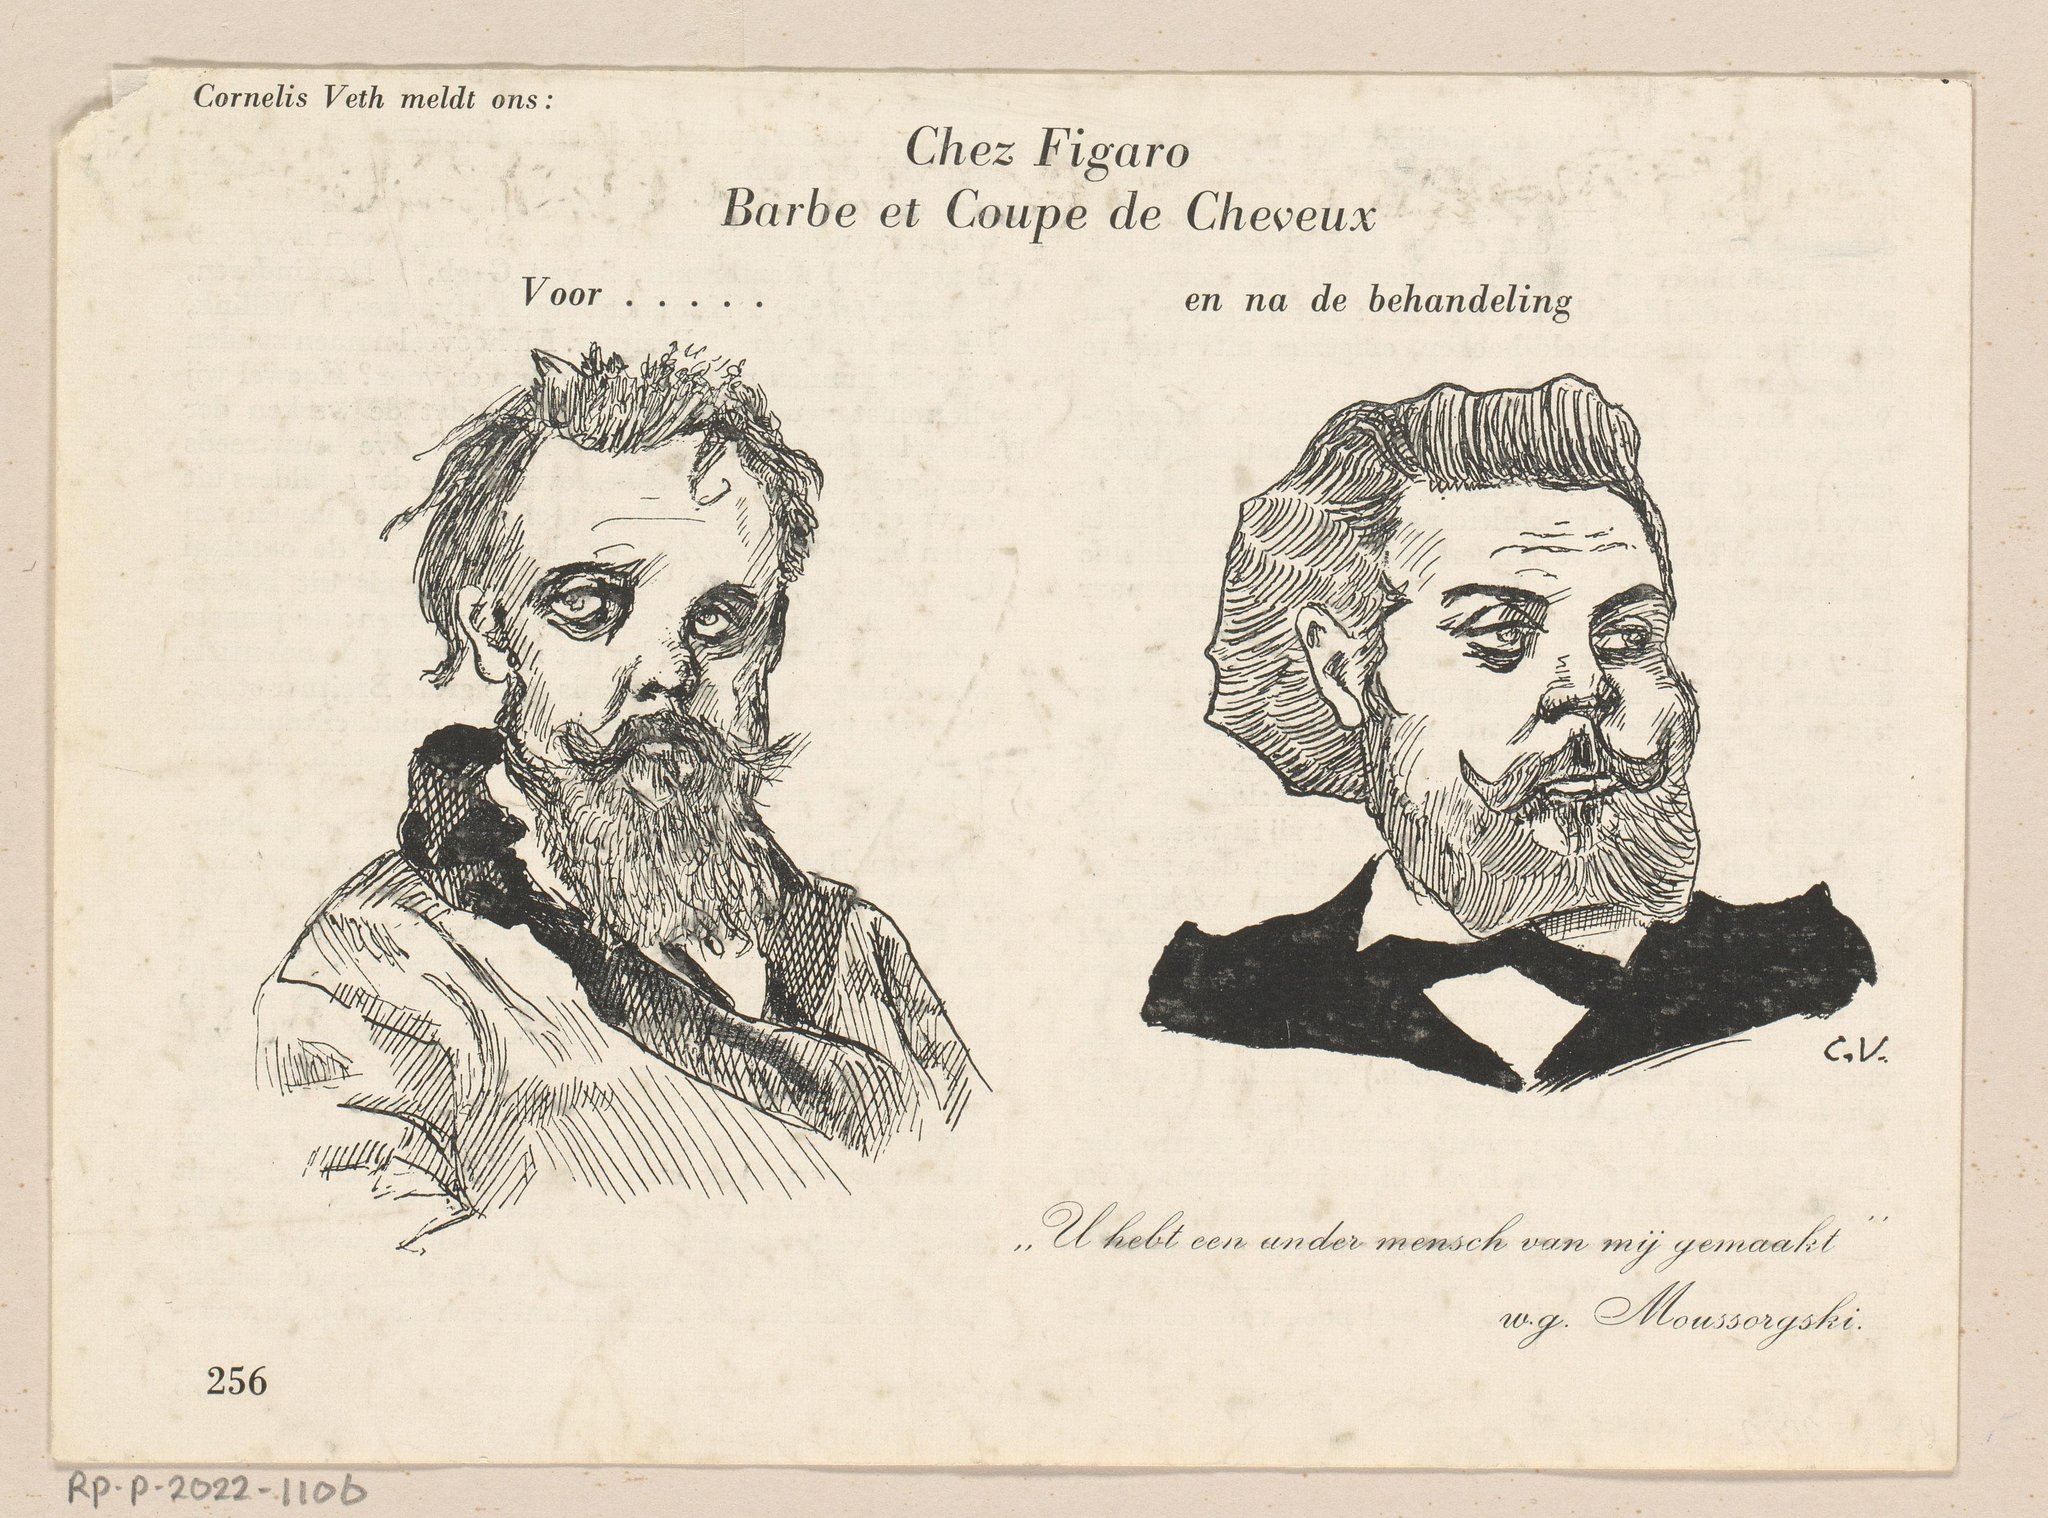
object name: photomechanical print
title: Portret van Modest Moessorgski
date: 1939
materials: paper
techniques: letterpress printing, line block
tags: historical persons, portrait of composer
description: Prent uit: Kroniek van hedendaagsche kunst en kultuur 5 (1939).